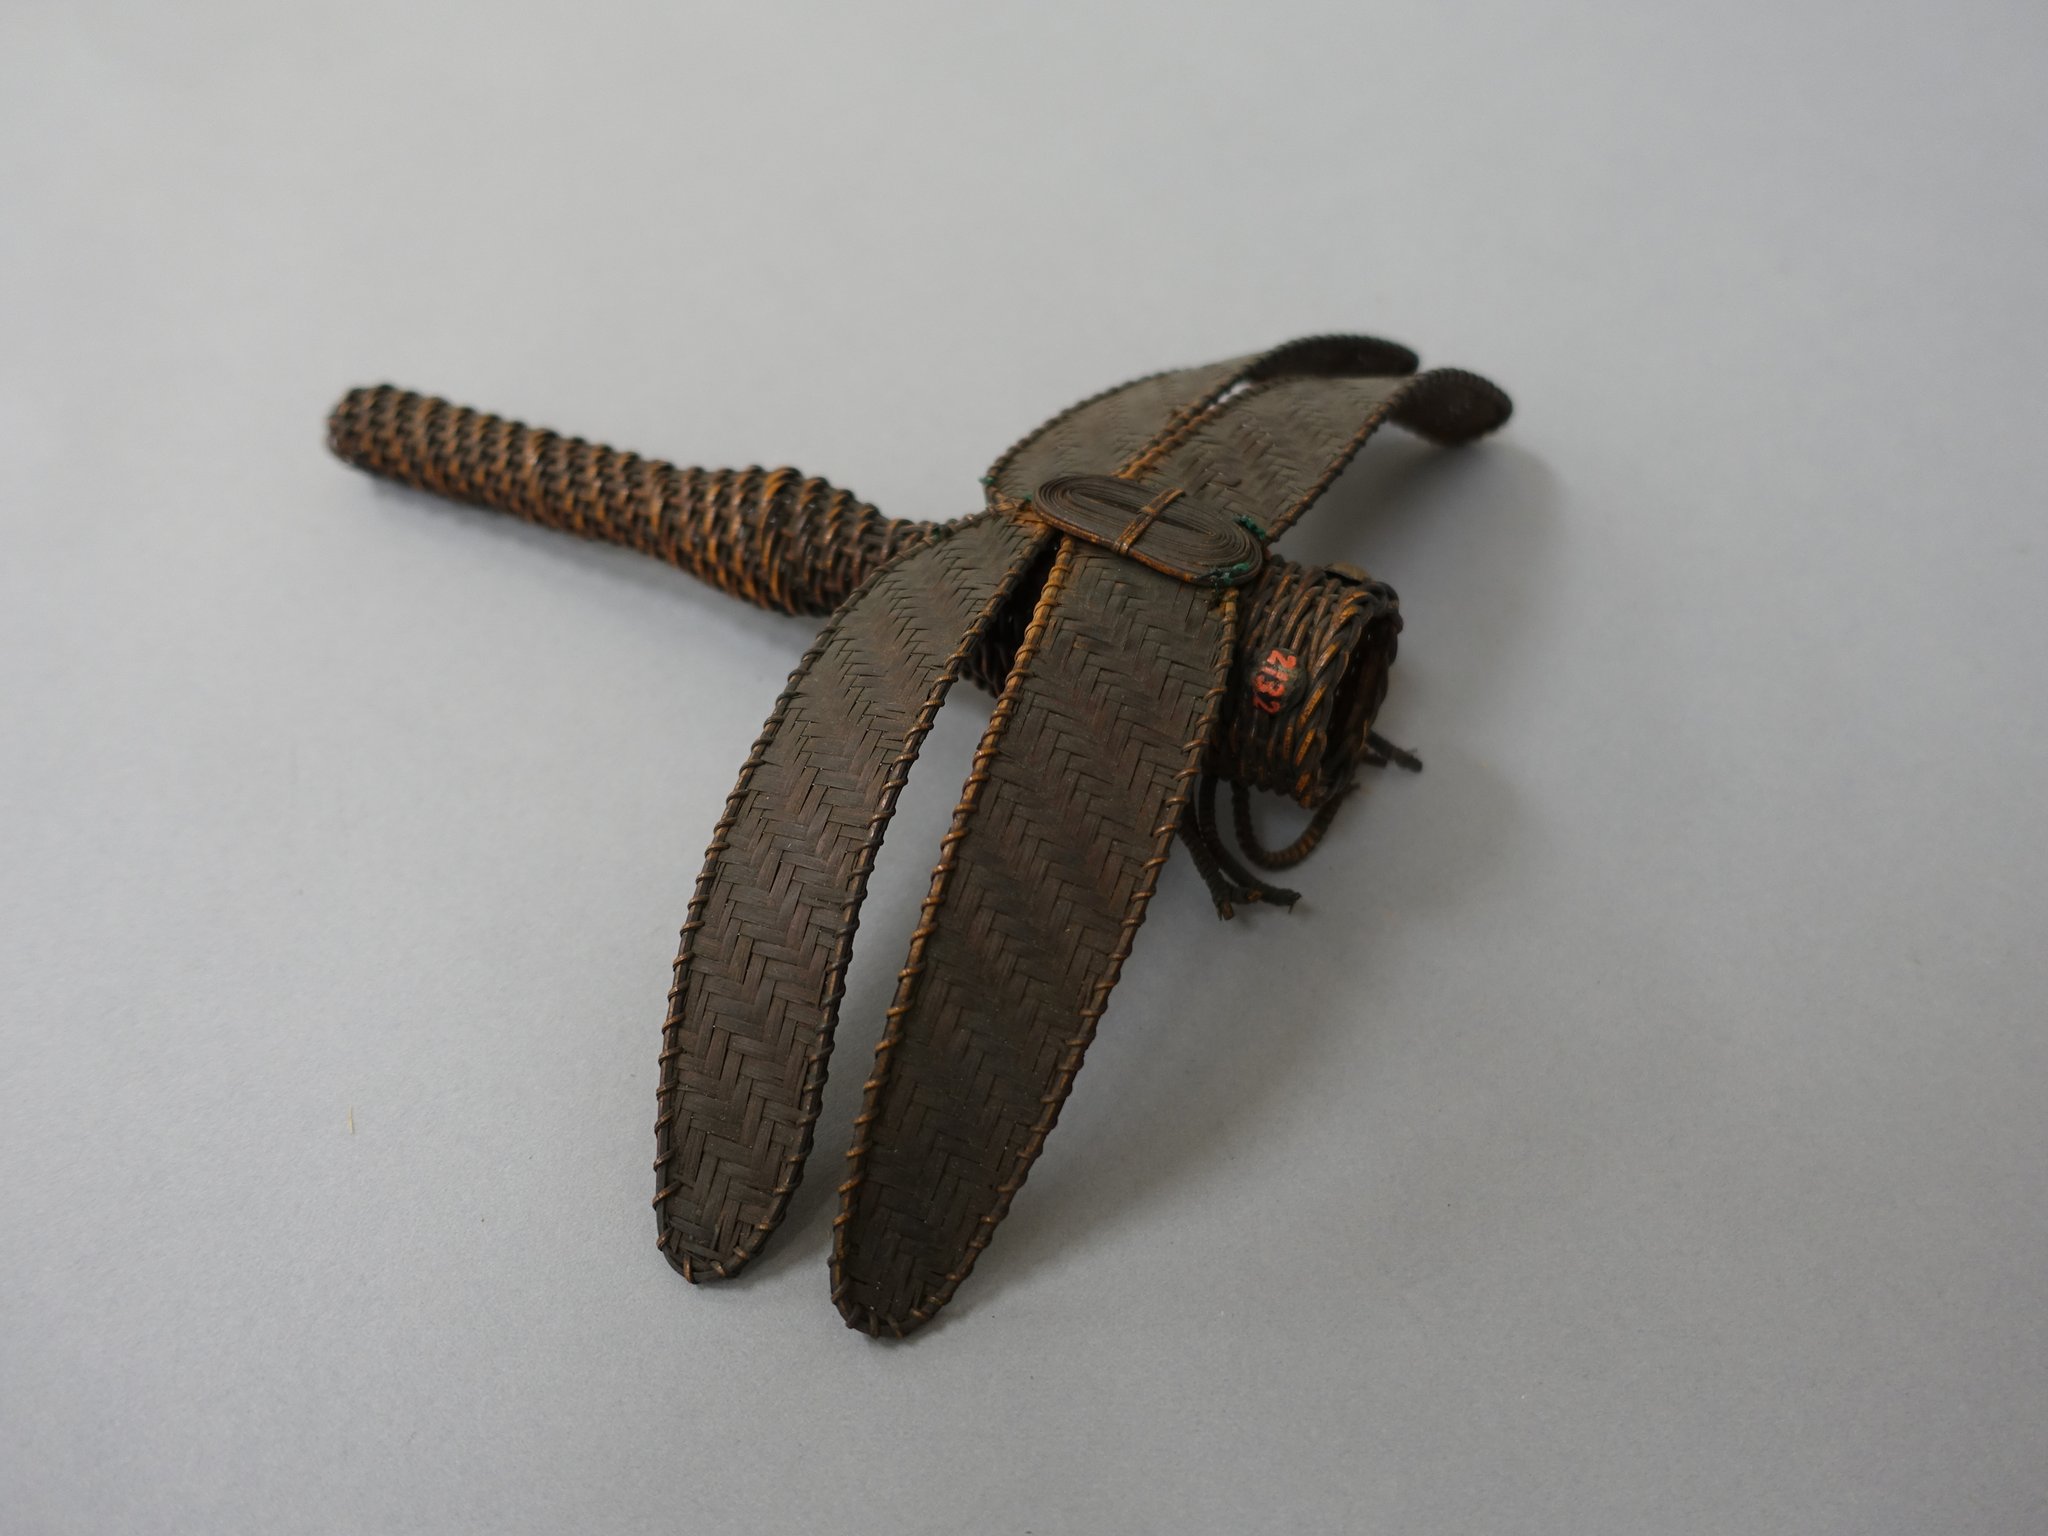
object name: ornament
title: Ornament (?)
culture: japanese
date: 1801-1900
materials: bamboo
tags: dragonflies